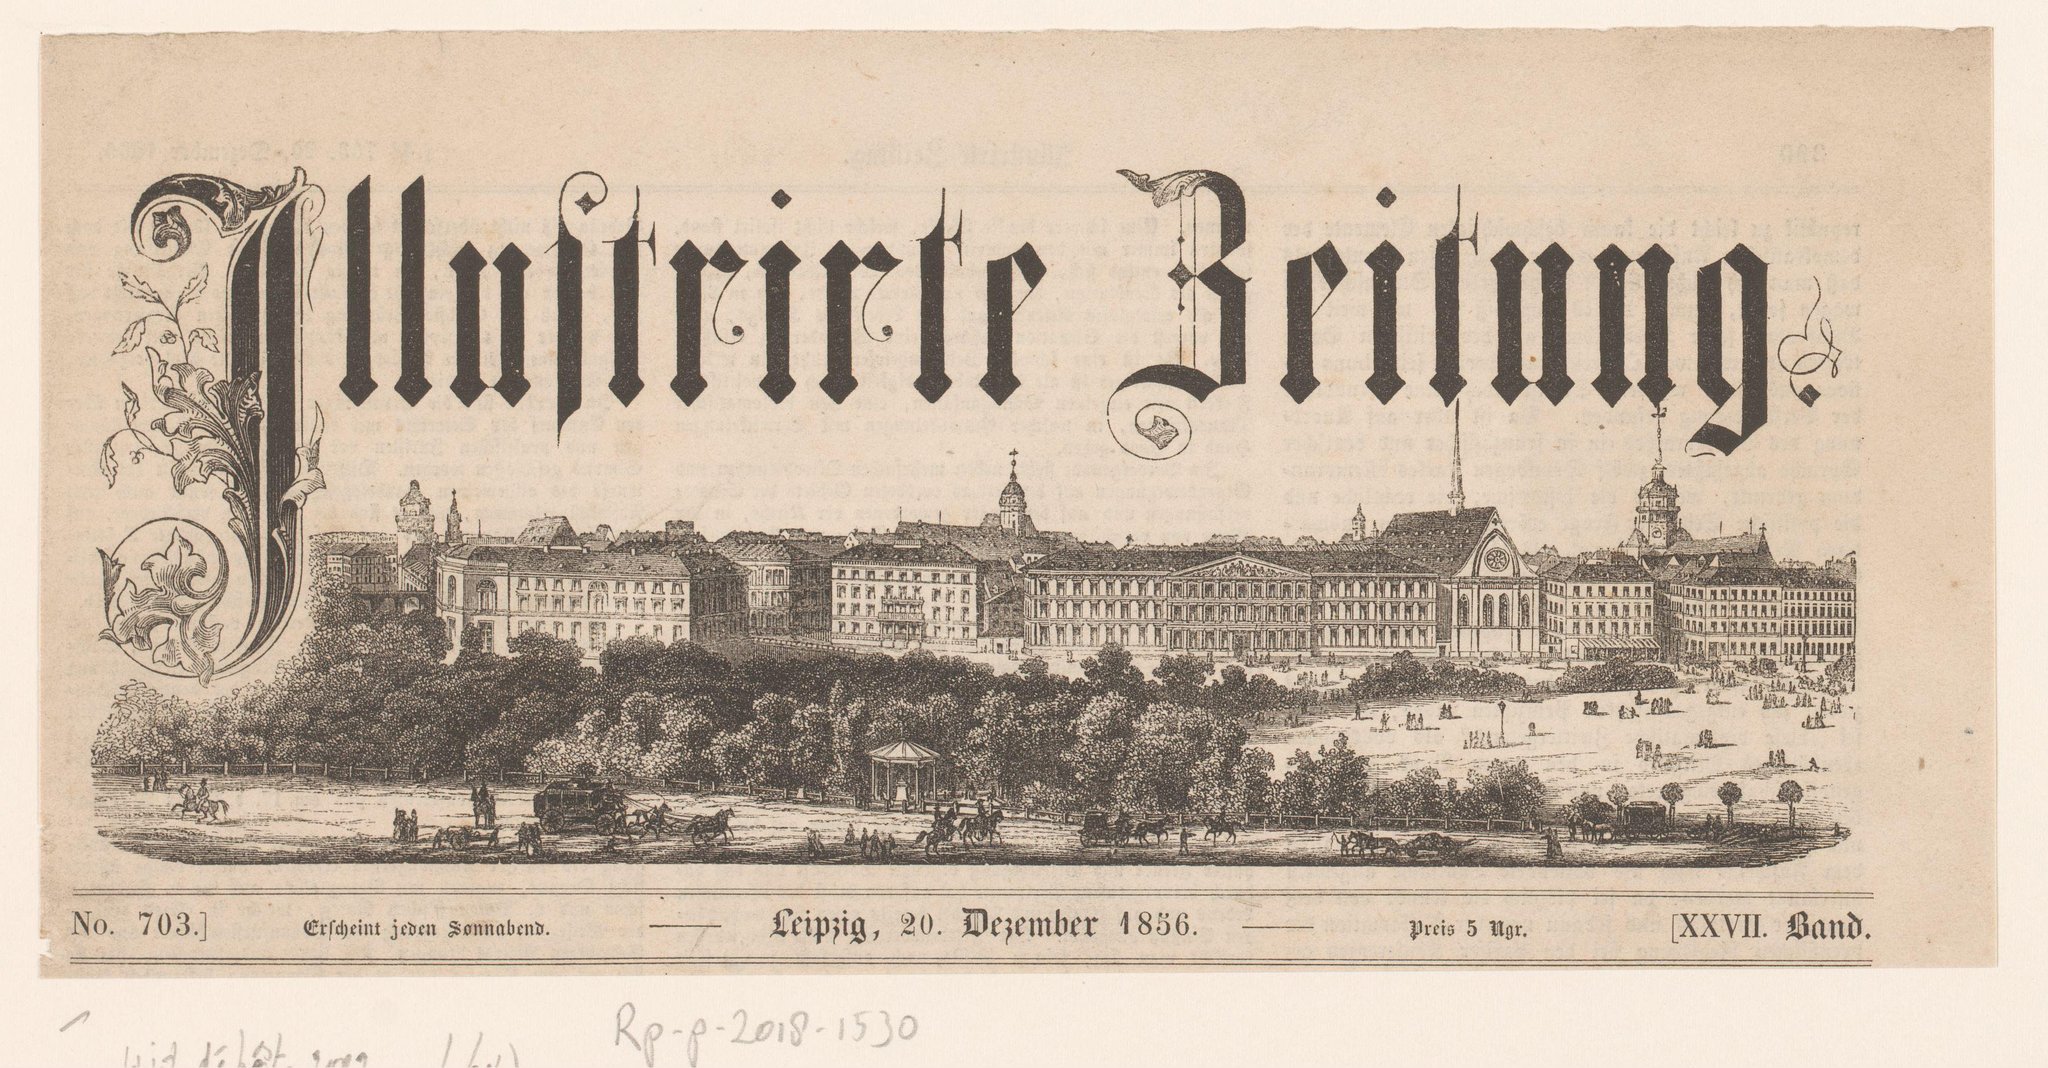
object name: print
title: Illustrirte Zeitung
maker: Anonymous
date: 1856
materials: paper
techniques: etching, letterpress printing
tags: prospect of city, town panorama, silhouette of city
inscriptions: date